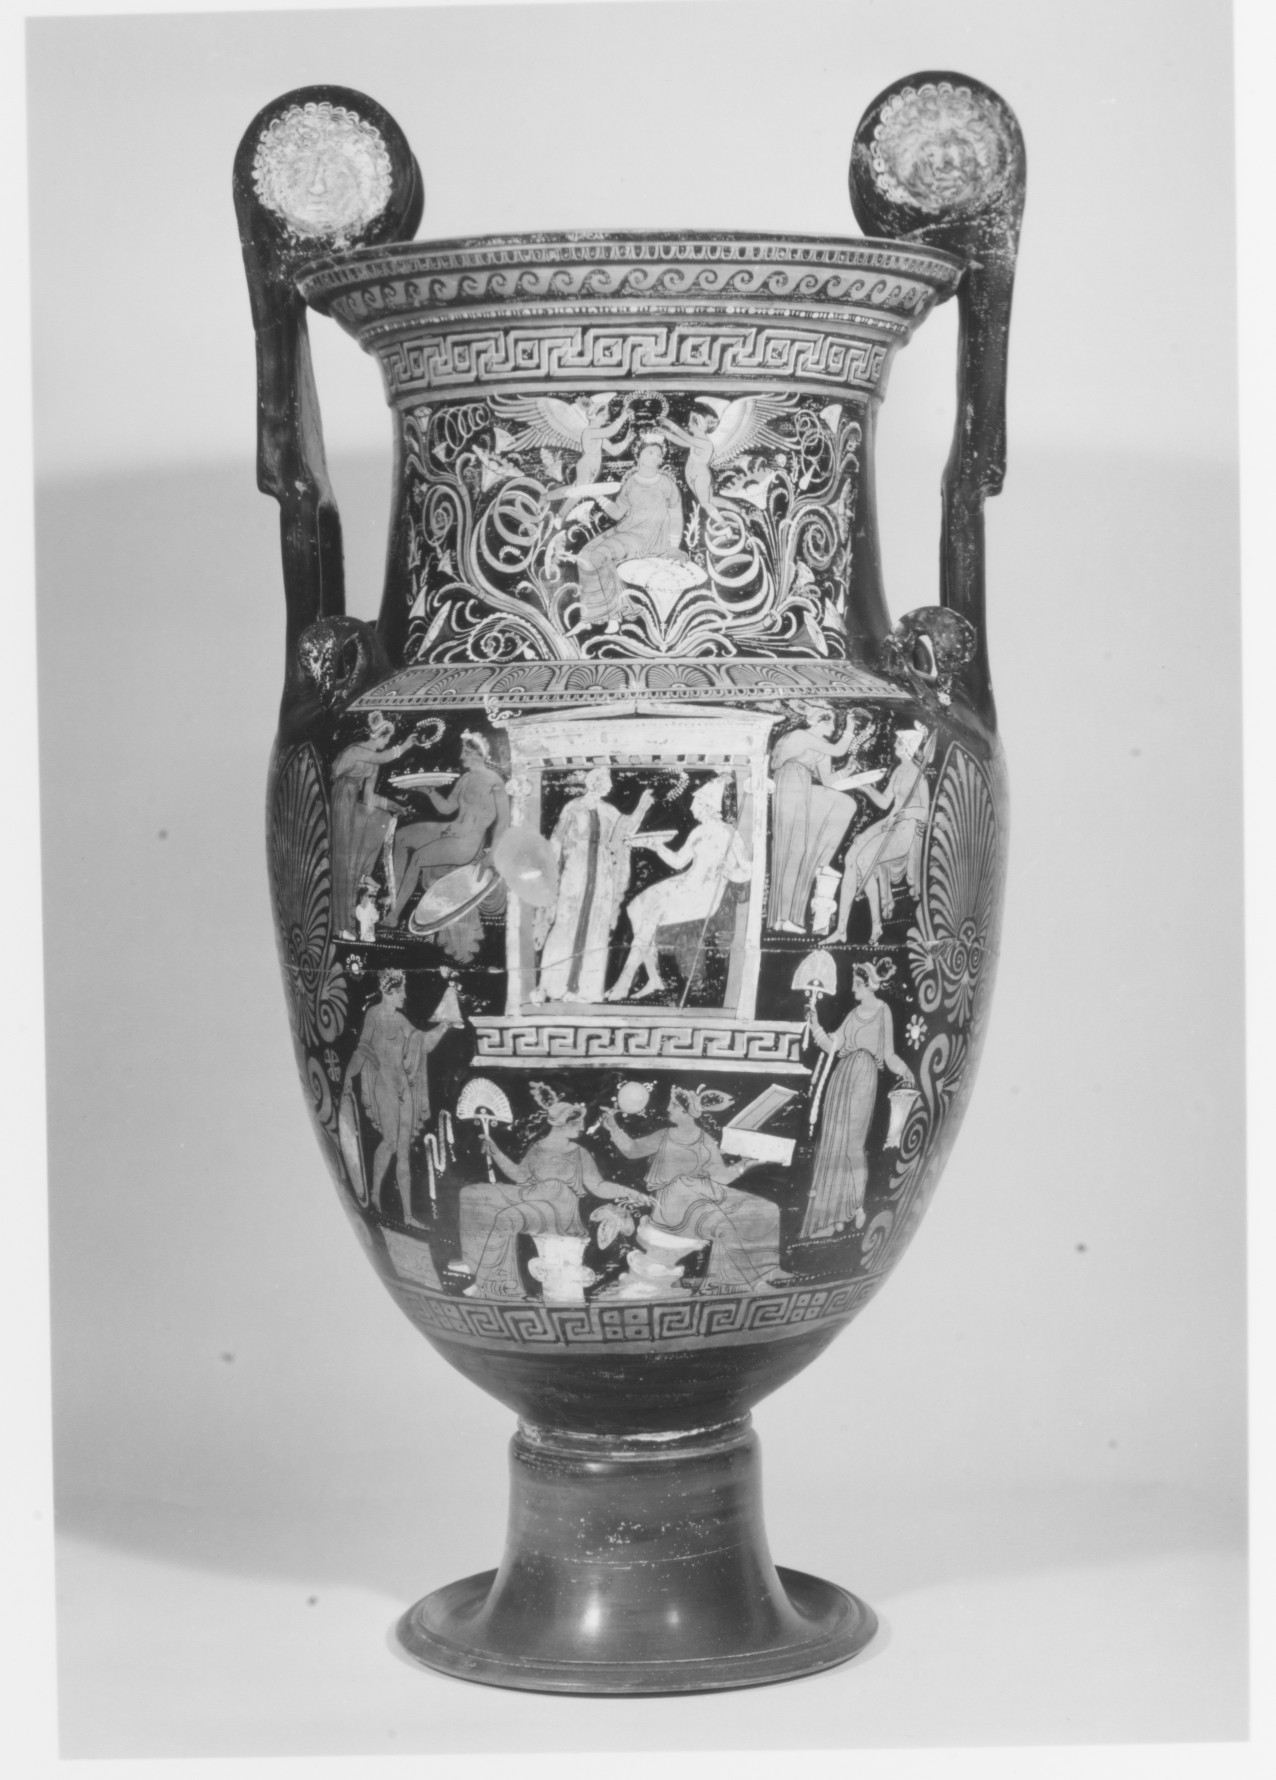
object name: volute krater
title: Terracotta volute-krater (mixing bowl)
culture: greek, south italian, apulian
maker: group of new york 17.210.240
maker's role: artist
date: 340-320 BCE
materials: terracotta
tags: fans,male nudes,women